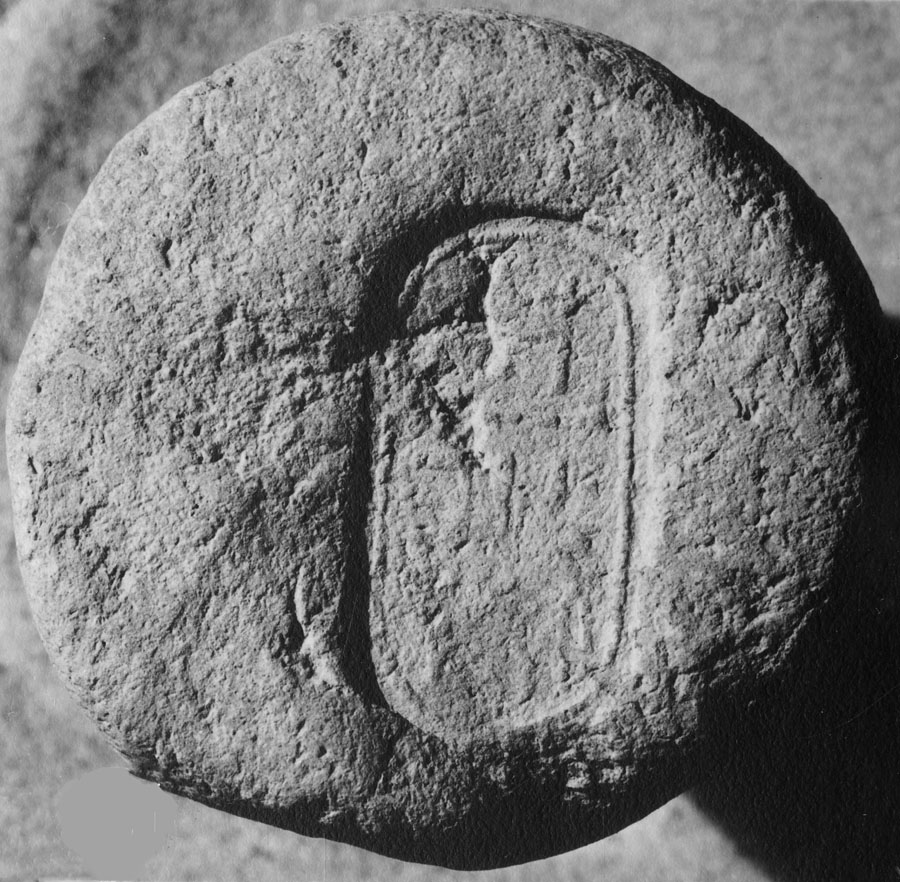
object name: cone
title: Funerary Cone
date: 1425-1400 BCE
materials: pottery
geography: egypt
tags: hieroglyphs